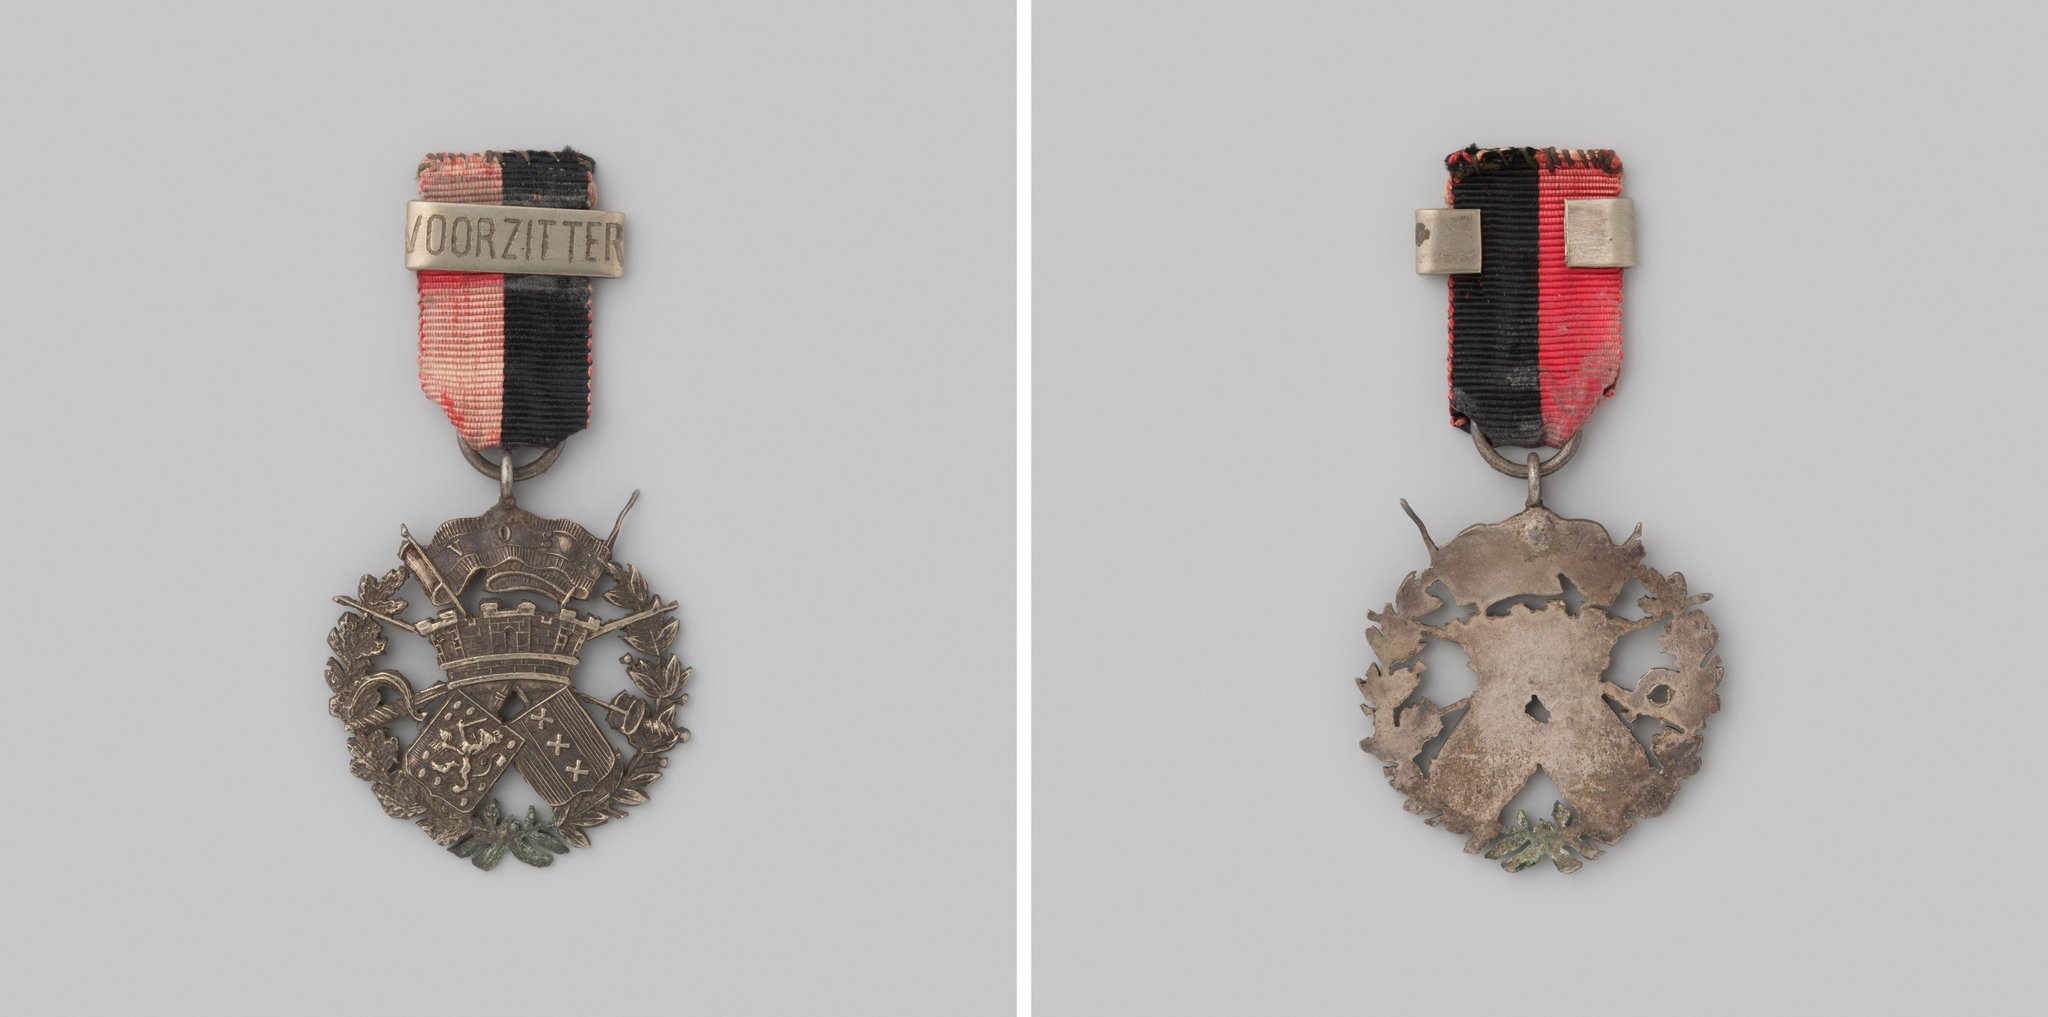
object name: insignia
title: Draagteken van de Vereeniging van de onderofficieren van de Schutterij te Amsterdam tot oefening in de wapenhandel (V.O.S.A.)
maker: Anonymous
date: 1880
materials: silver, textile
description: Zilveren draagteken met oog, ring en lint, met om het lint een zilveren band waarop gegraveerd VOORZITTER.